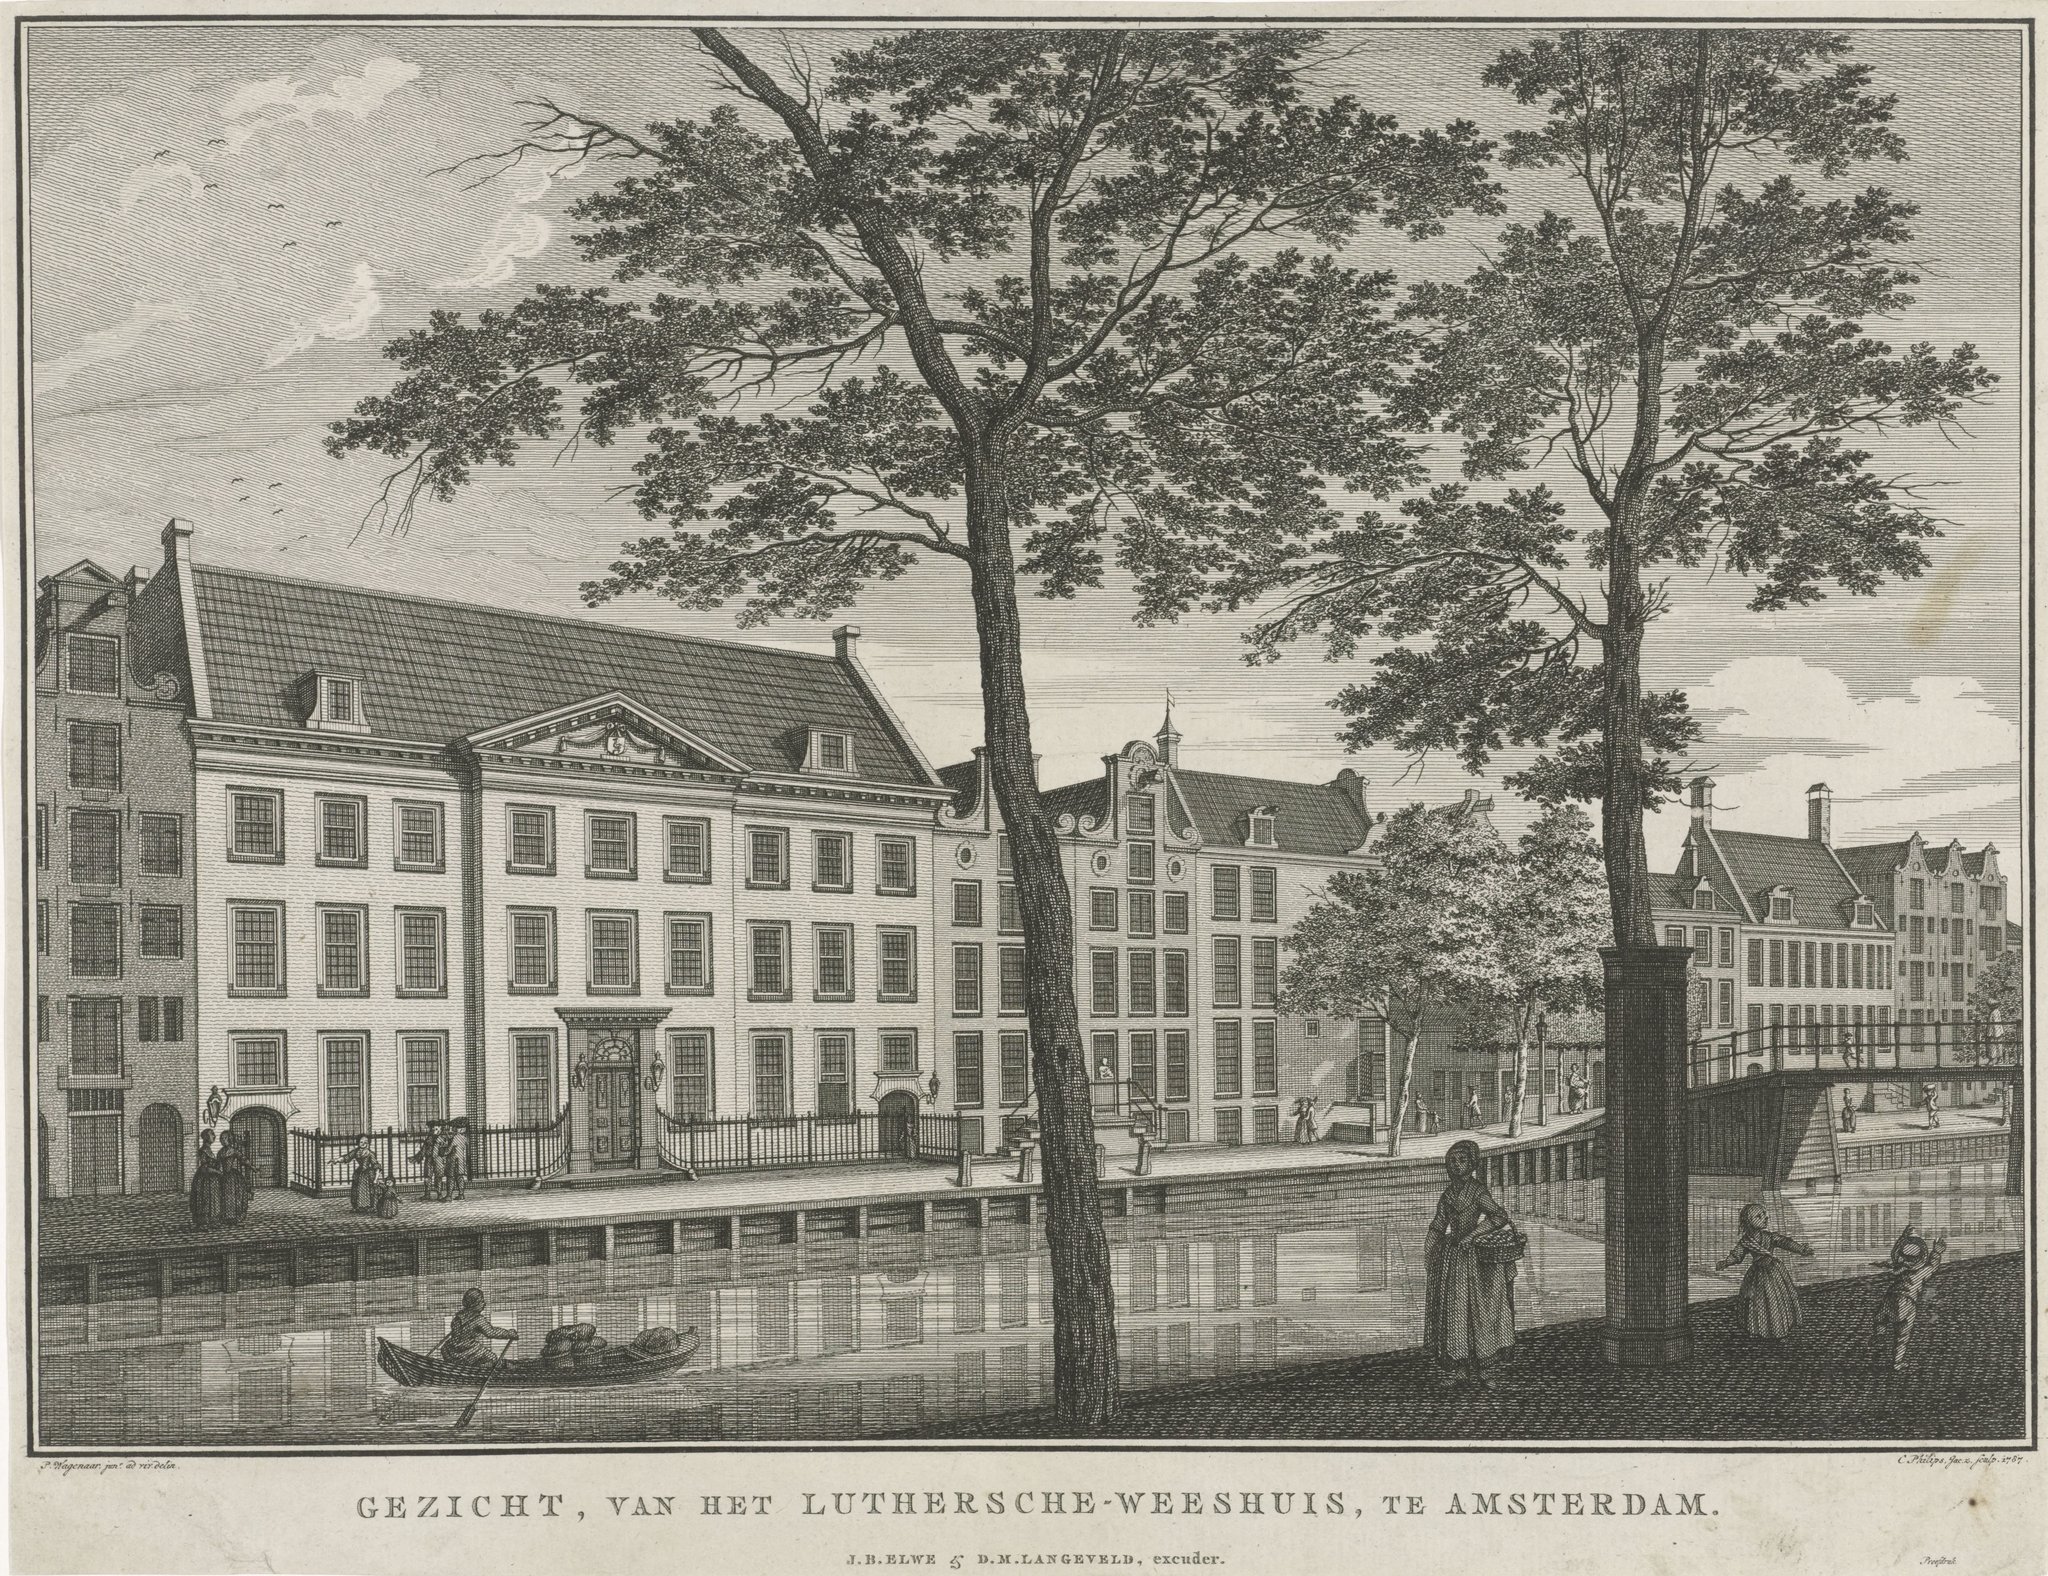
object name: print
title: Gezicht op het Lutherse Diaconieweeshuis te Amsterdam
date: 1787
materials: paper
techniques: etching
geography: amsterdam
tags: orphanage, civic architecture; edifices; dwellings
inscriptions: collector's mark: Lugt 2228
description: Gezicht op het Lutherse Weeshuis, aan de Lauriergracht. Rechts de ingang naar de Tweede Laurierdwarsstraat.